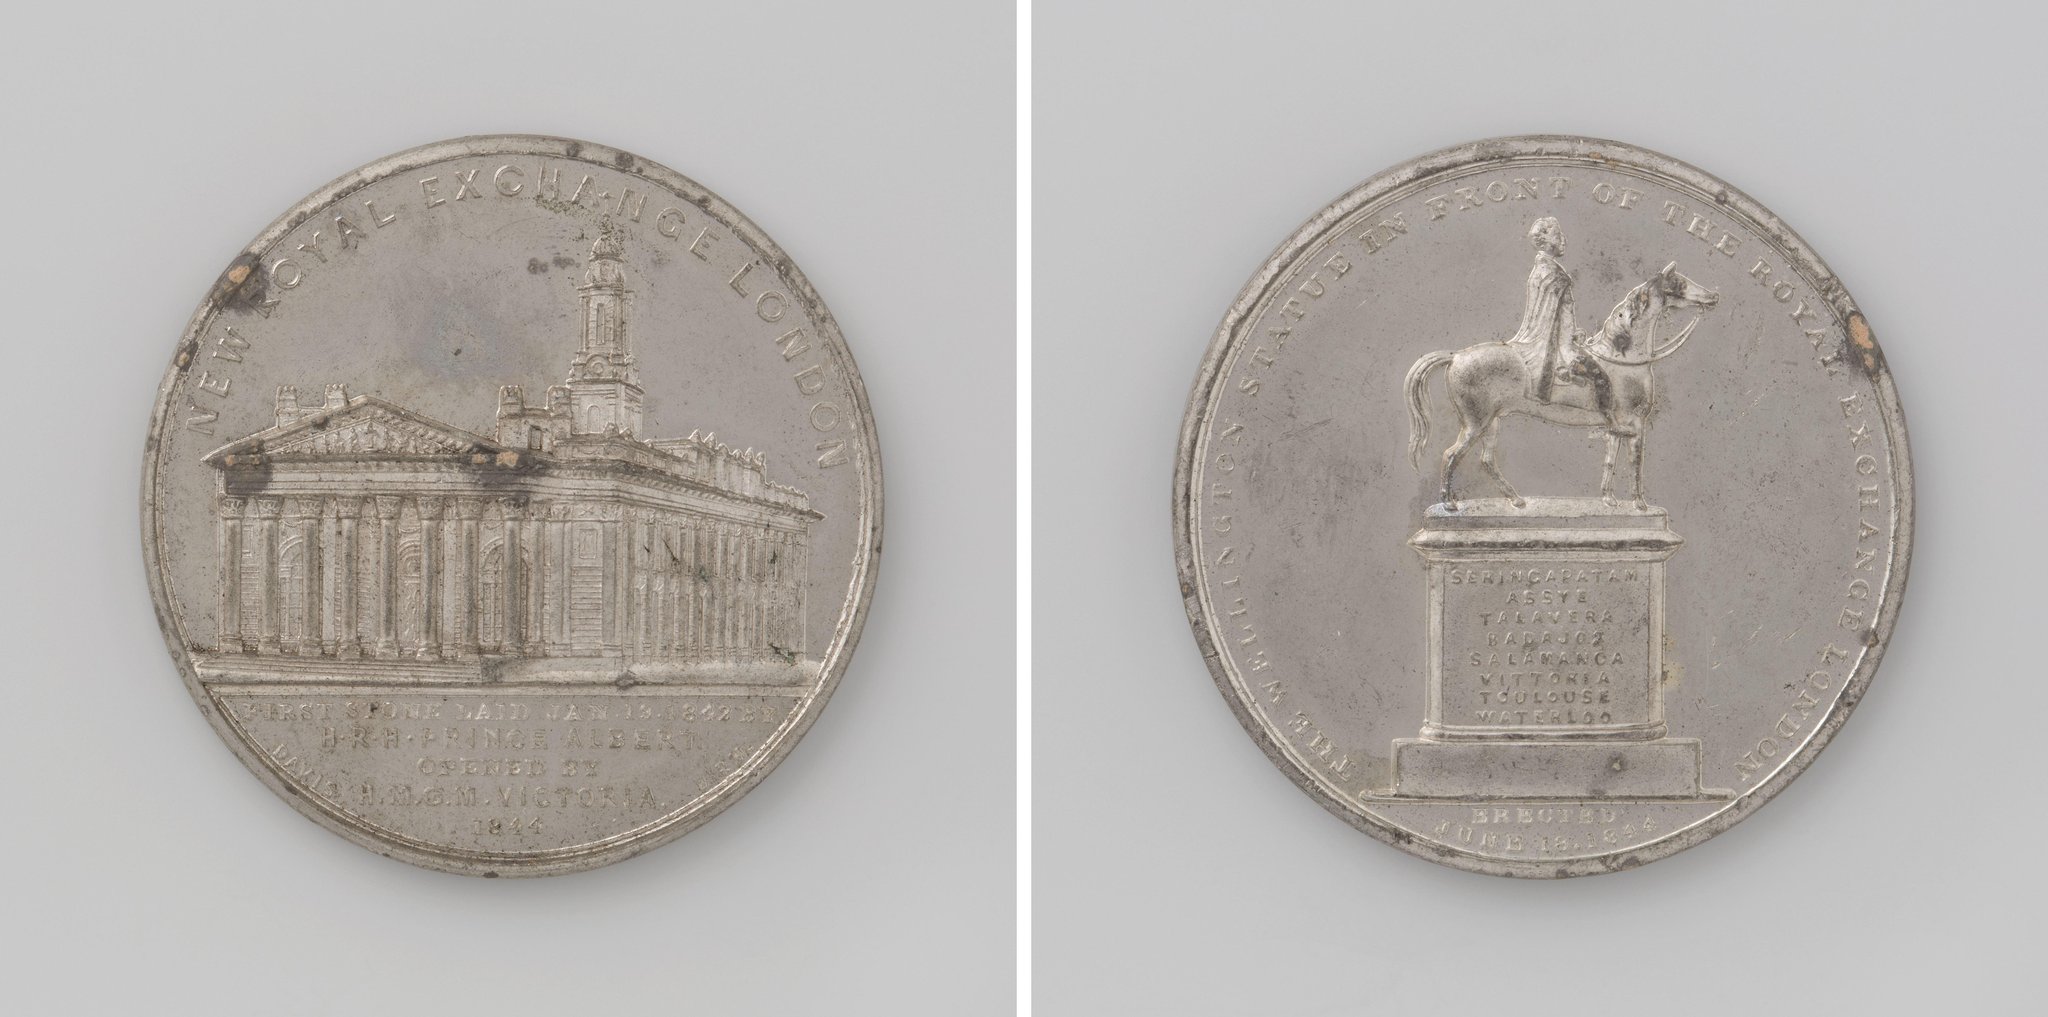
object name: history medal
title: Opening van de Nieuwe Beurs te Londen en oprichting van een standbeeld voor de hertog van Wellington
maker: joseph davis (medailleur)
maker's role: goldsmith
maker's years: -1857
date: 1844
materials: silver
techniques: striking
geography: birmingham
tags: victoria (koningin van het verenigd koninkrijk en keizerin van india), albert (prins van saksen-coburg en gotha), walmer castle, arthur wellesley of wellington, london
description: Zilveren penning. Voorzijde: gezicht op het nieuwe beursgebouw binnen omschrift; afsnede: opschrift. Keerzijde: ruiterstandbeeld op sokkel met opschrift binnen omschrift